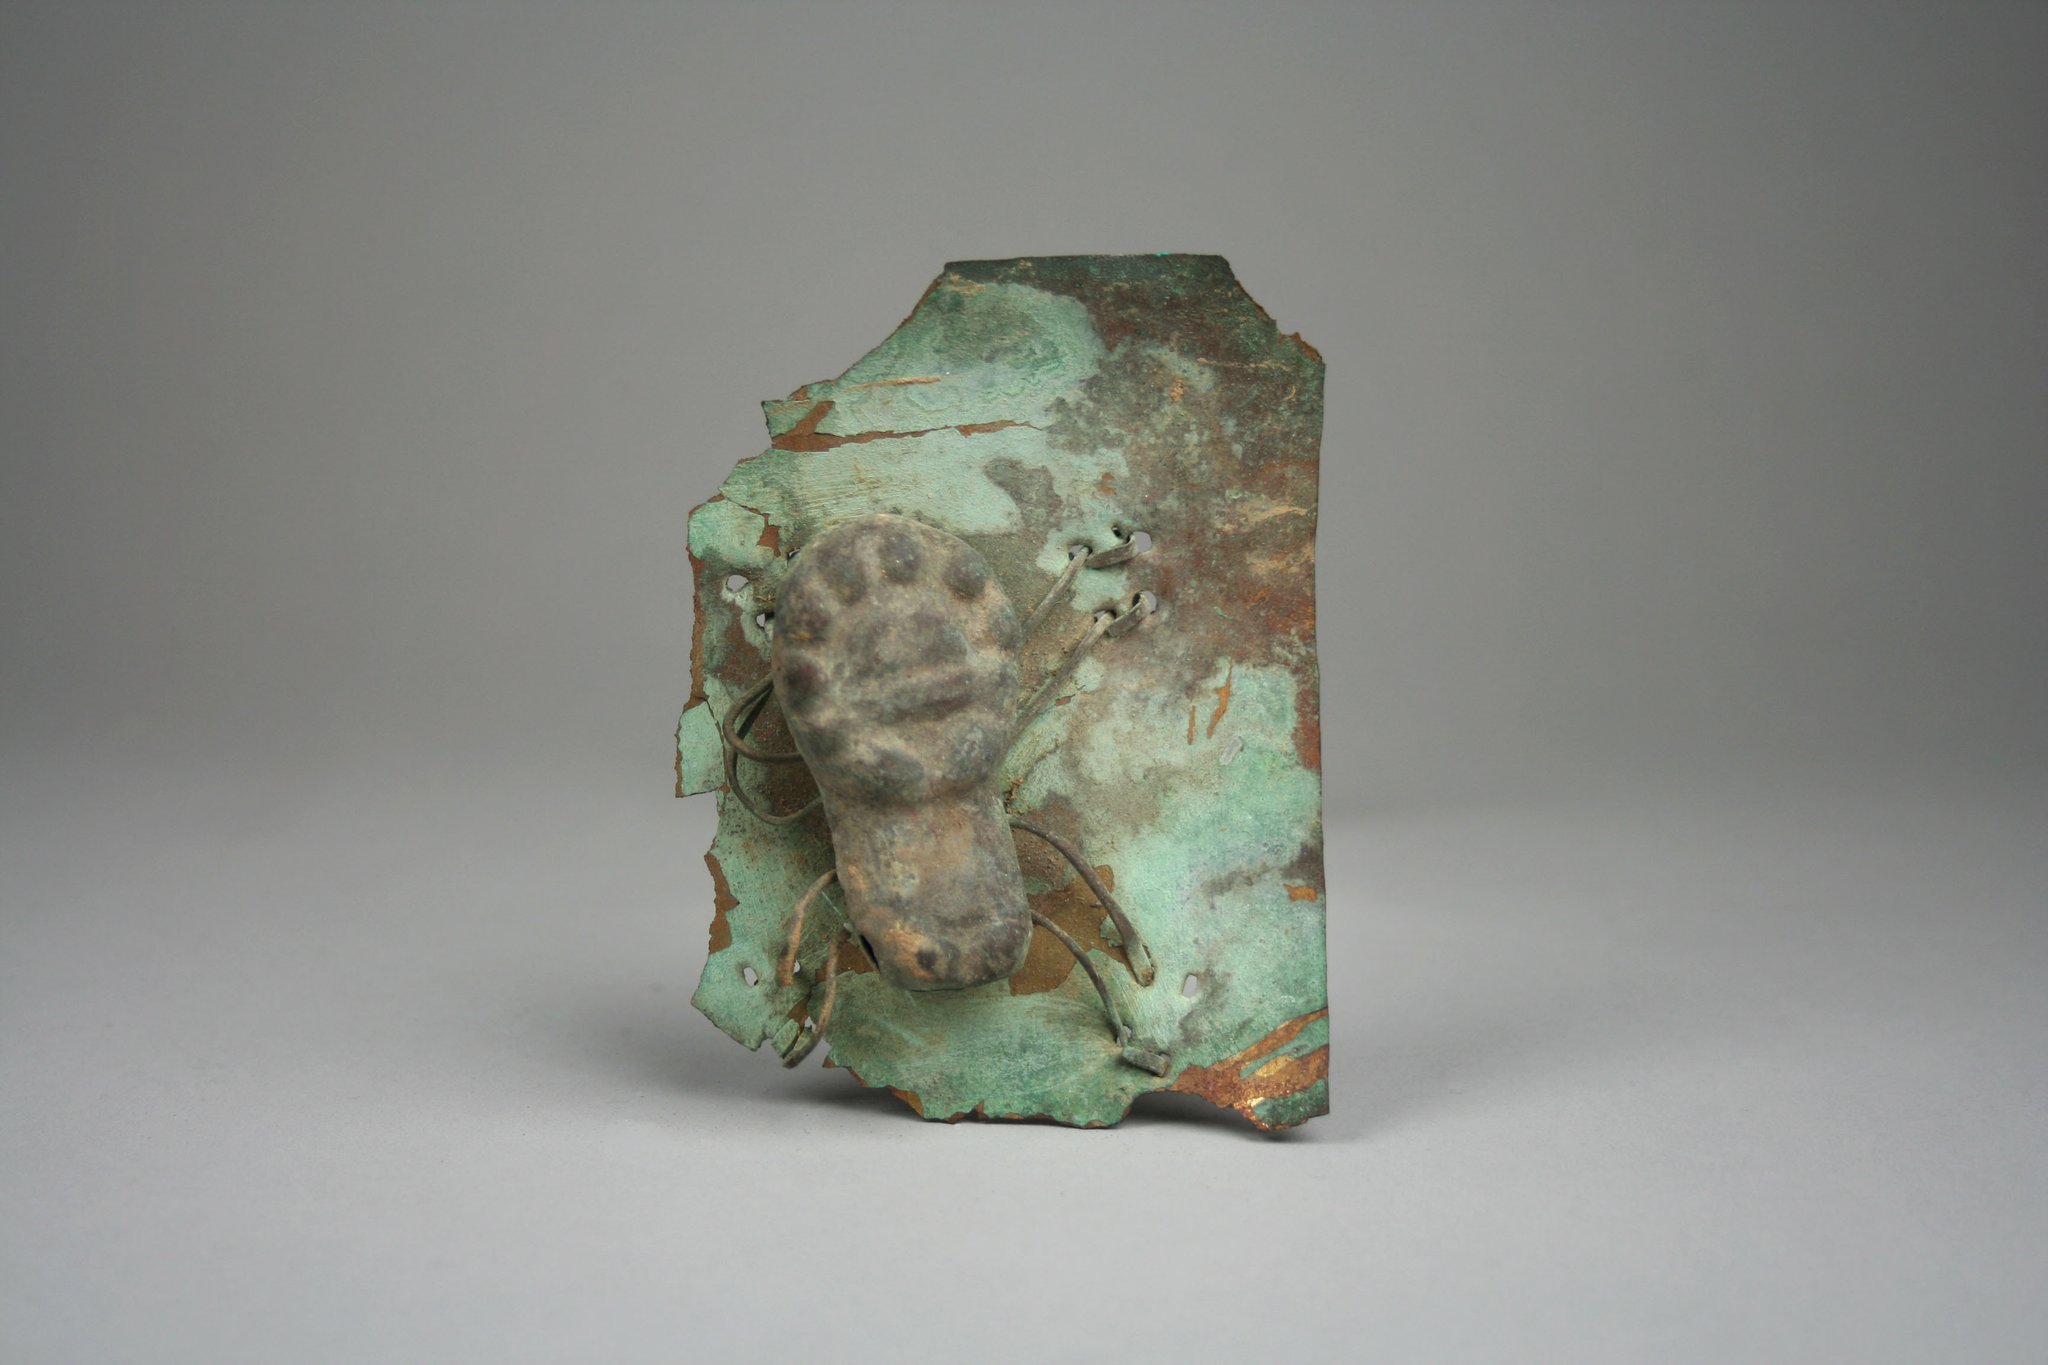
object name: ornament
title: Spider Ornament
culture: moche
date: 501-700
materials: gilt copper, metal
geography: peru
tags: animals